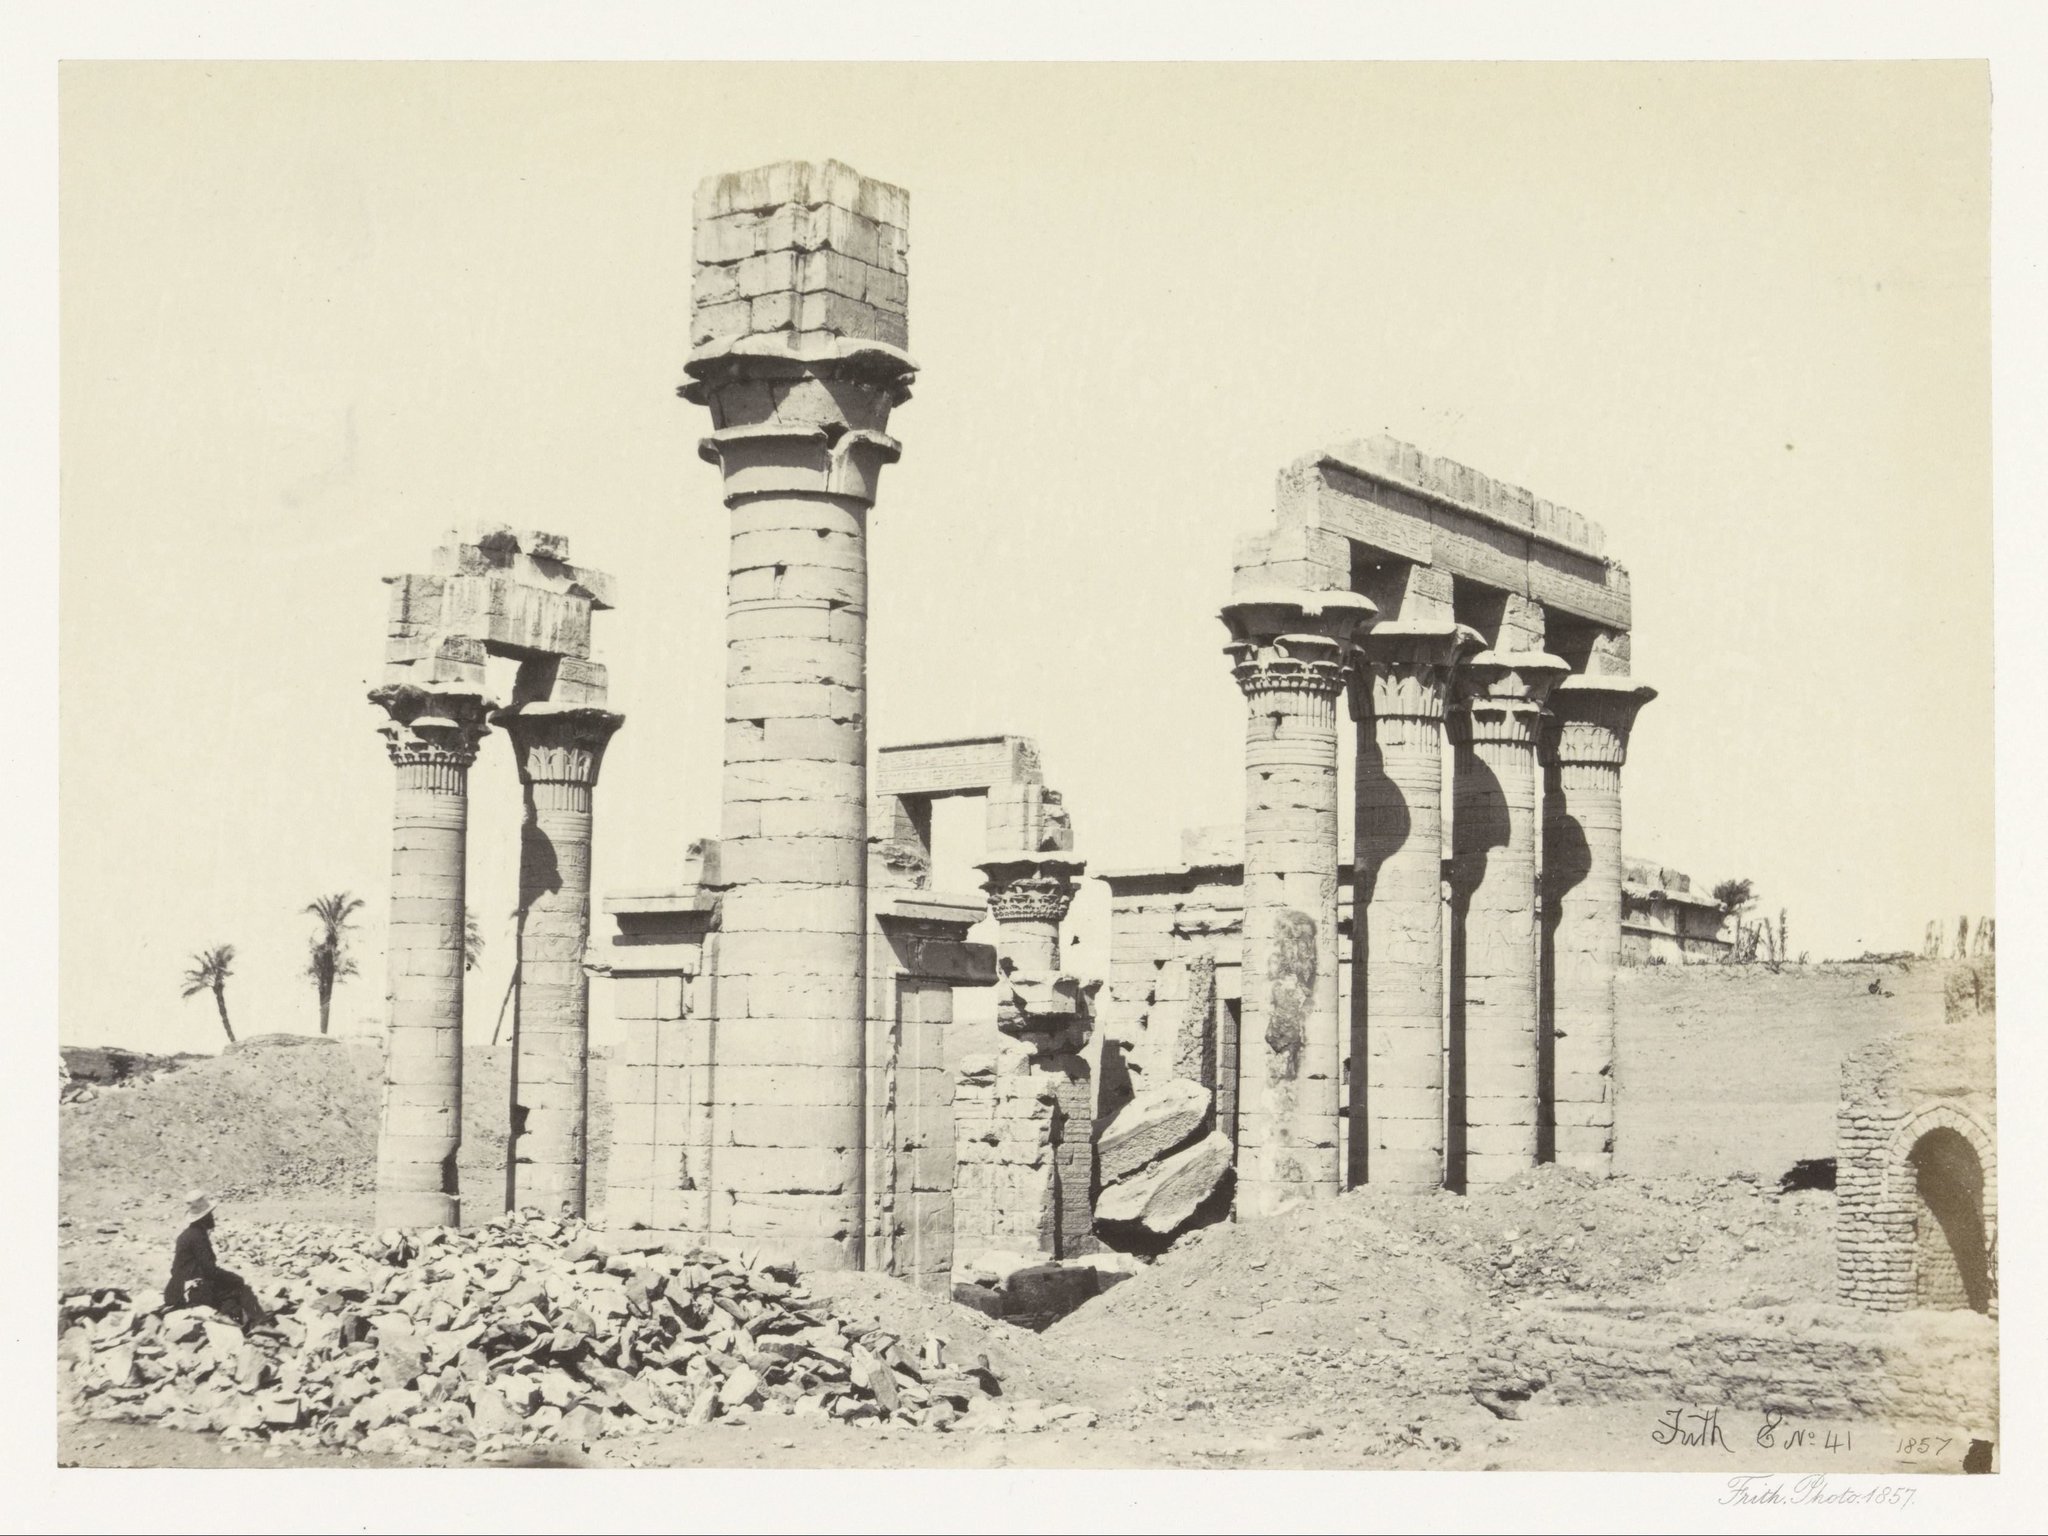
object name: page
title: Restanten van Cleopatra's tempel in Armant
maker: francis frith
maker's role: publisher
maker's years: 1822-1898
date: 1857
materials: paper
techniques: albumen print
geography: armant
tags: temple, shrine ~ egyptian religion, ruin of a building ~ architecture